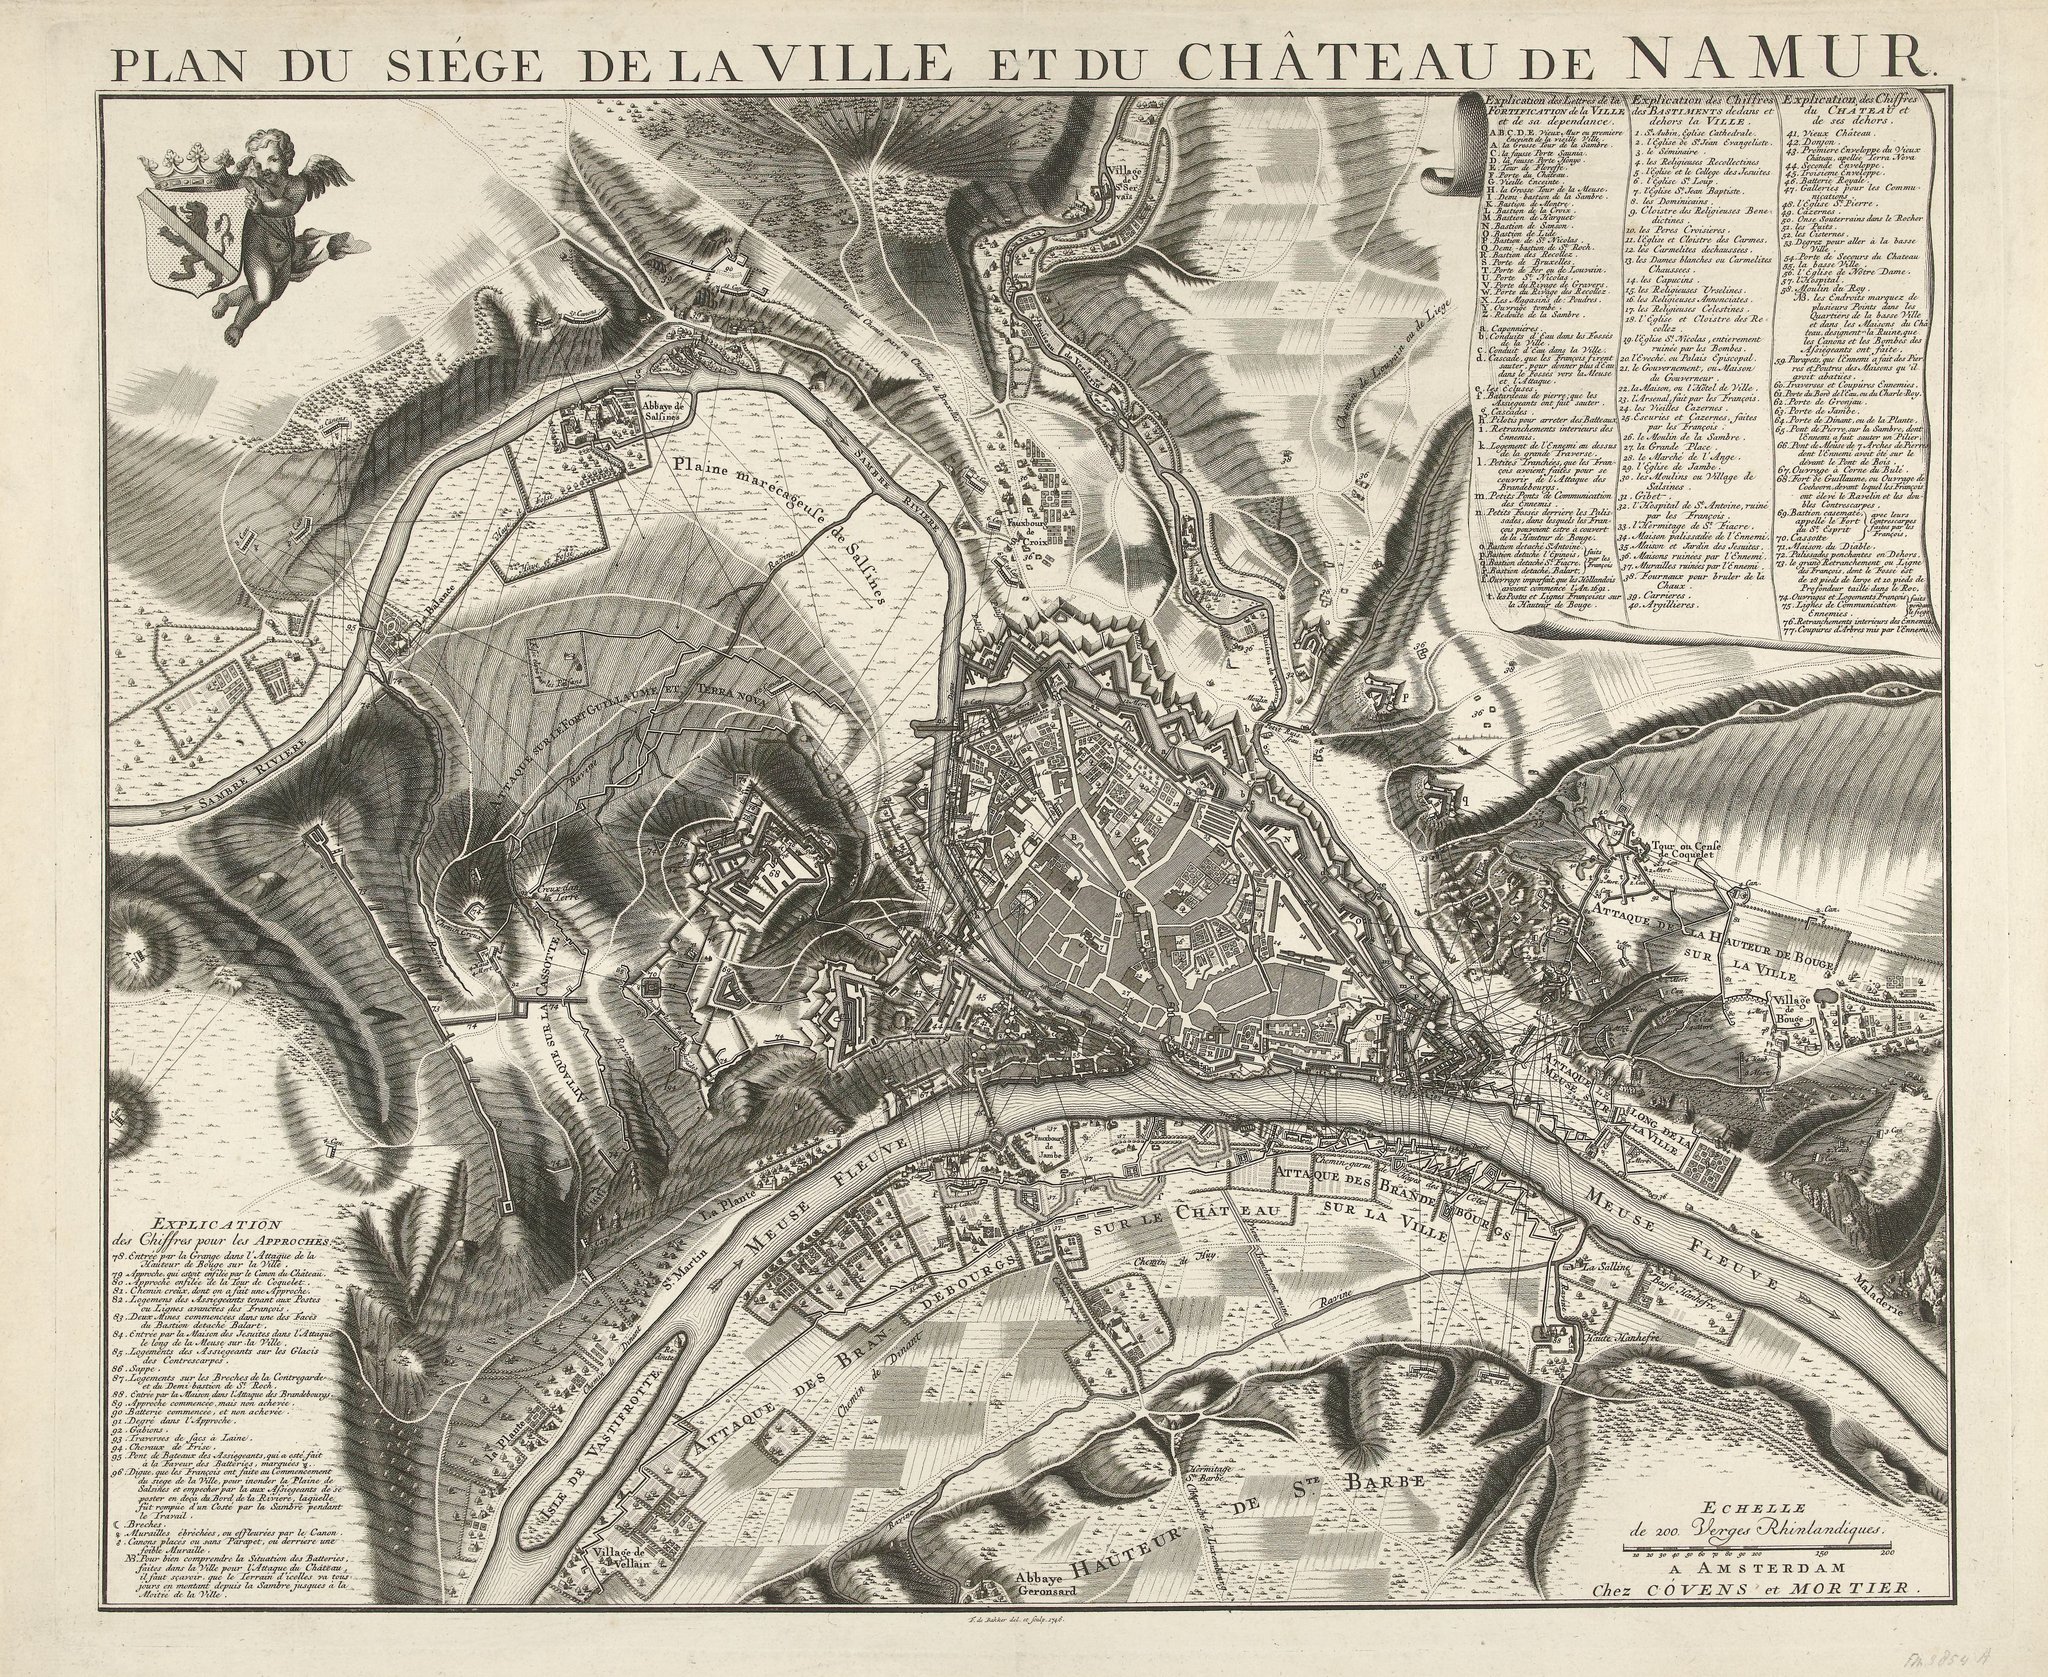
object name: print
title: Plan du Siége de la Ville et du Château de Namur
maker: frans de bakker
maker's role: print maker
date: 1746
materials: paper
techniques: engraving, etching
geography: amsterdam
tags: maps of separate countries or regions, siege, position war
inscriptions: collector's mark: Lugt 2166, collector's mark: Lugt 2228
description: Gedetailleerd plan van de stad Namen en alle versterkingen om de stad, belegerd vanaf 12-13 september en door de Fransen ingenomen op 19 september 1746. Rechtsboven en linksonder legenda's in het Frans.